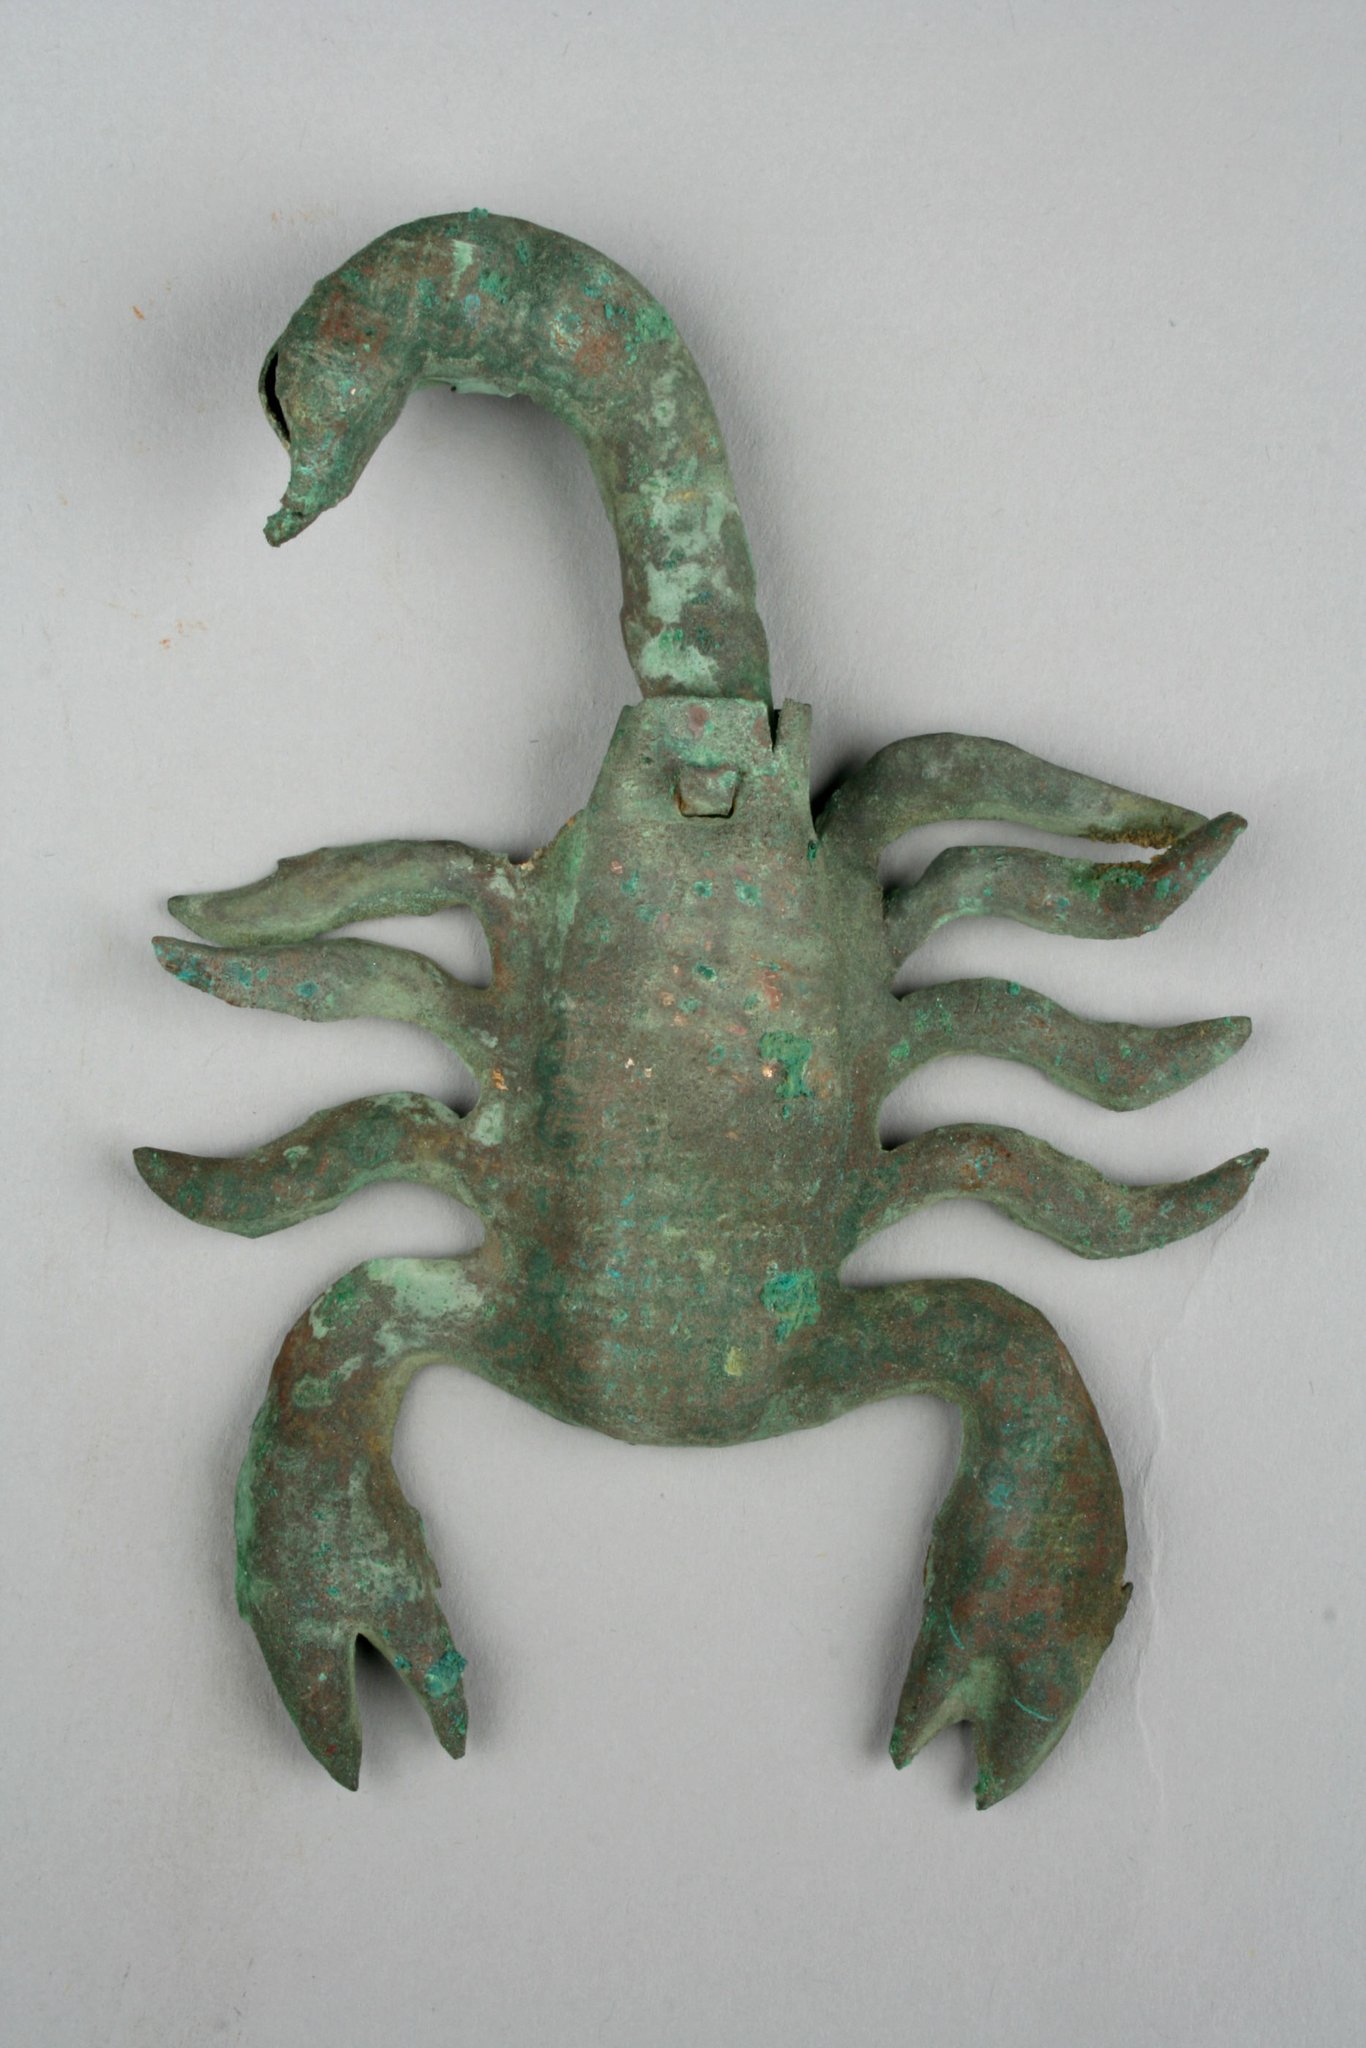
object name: ornament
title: Scorpion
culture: moche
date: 501-700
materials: gilt copper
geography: peru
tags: scorpions